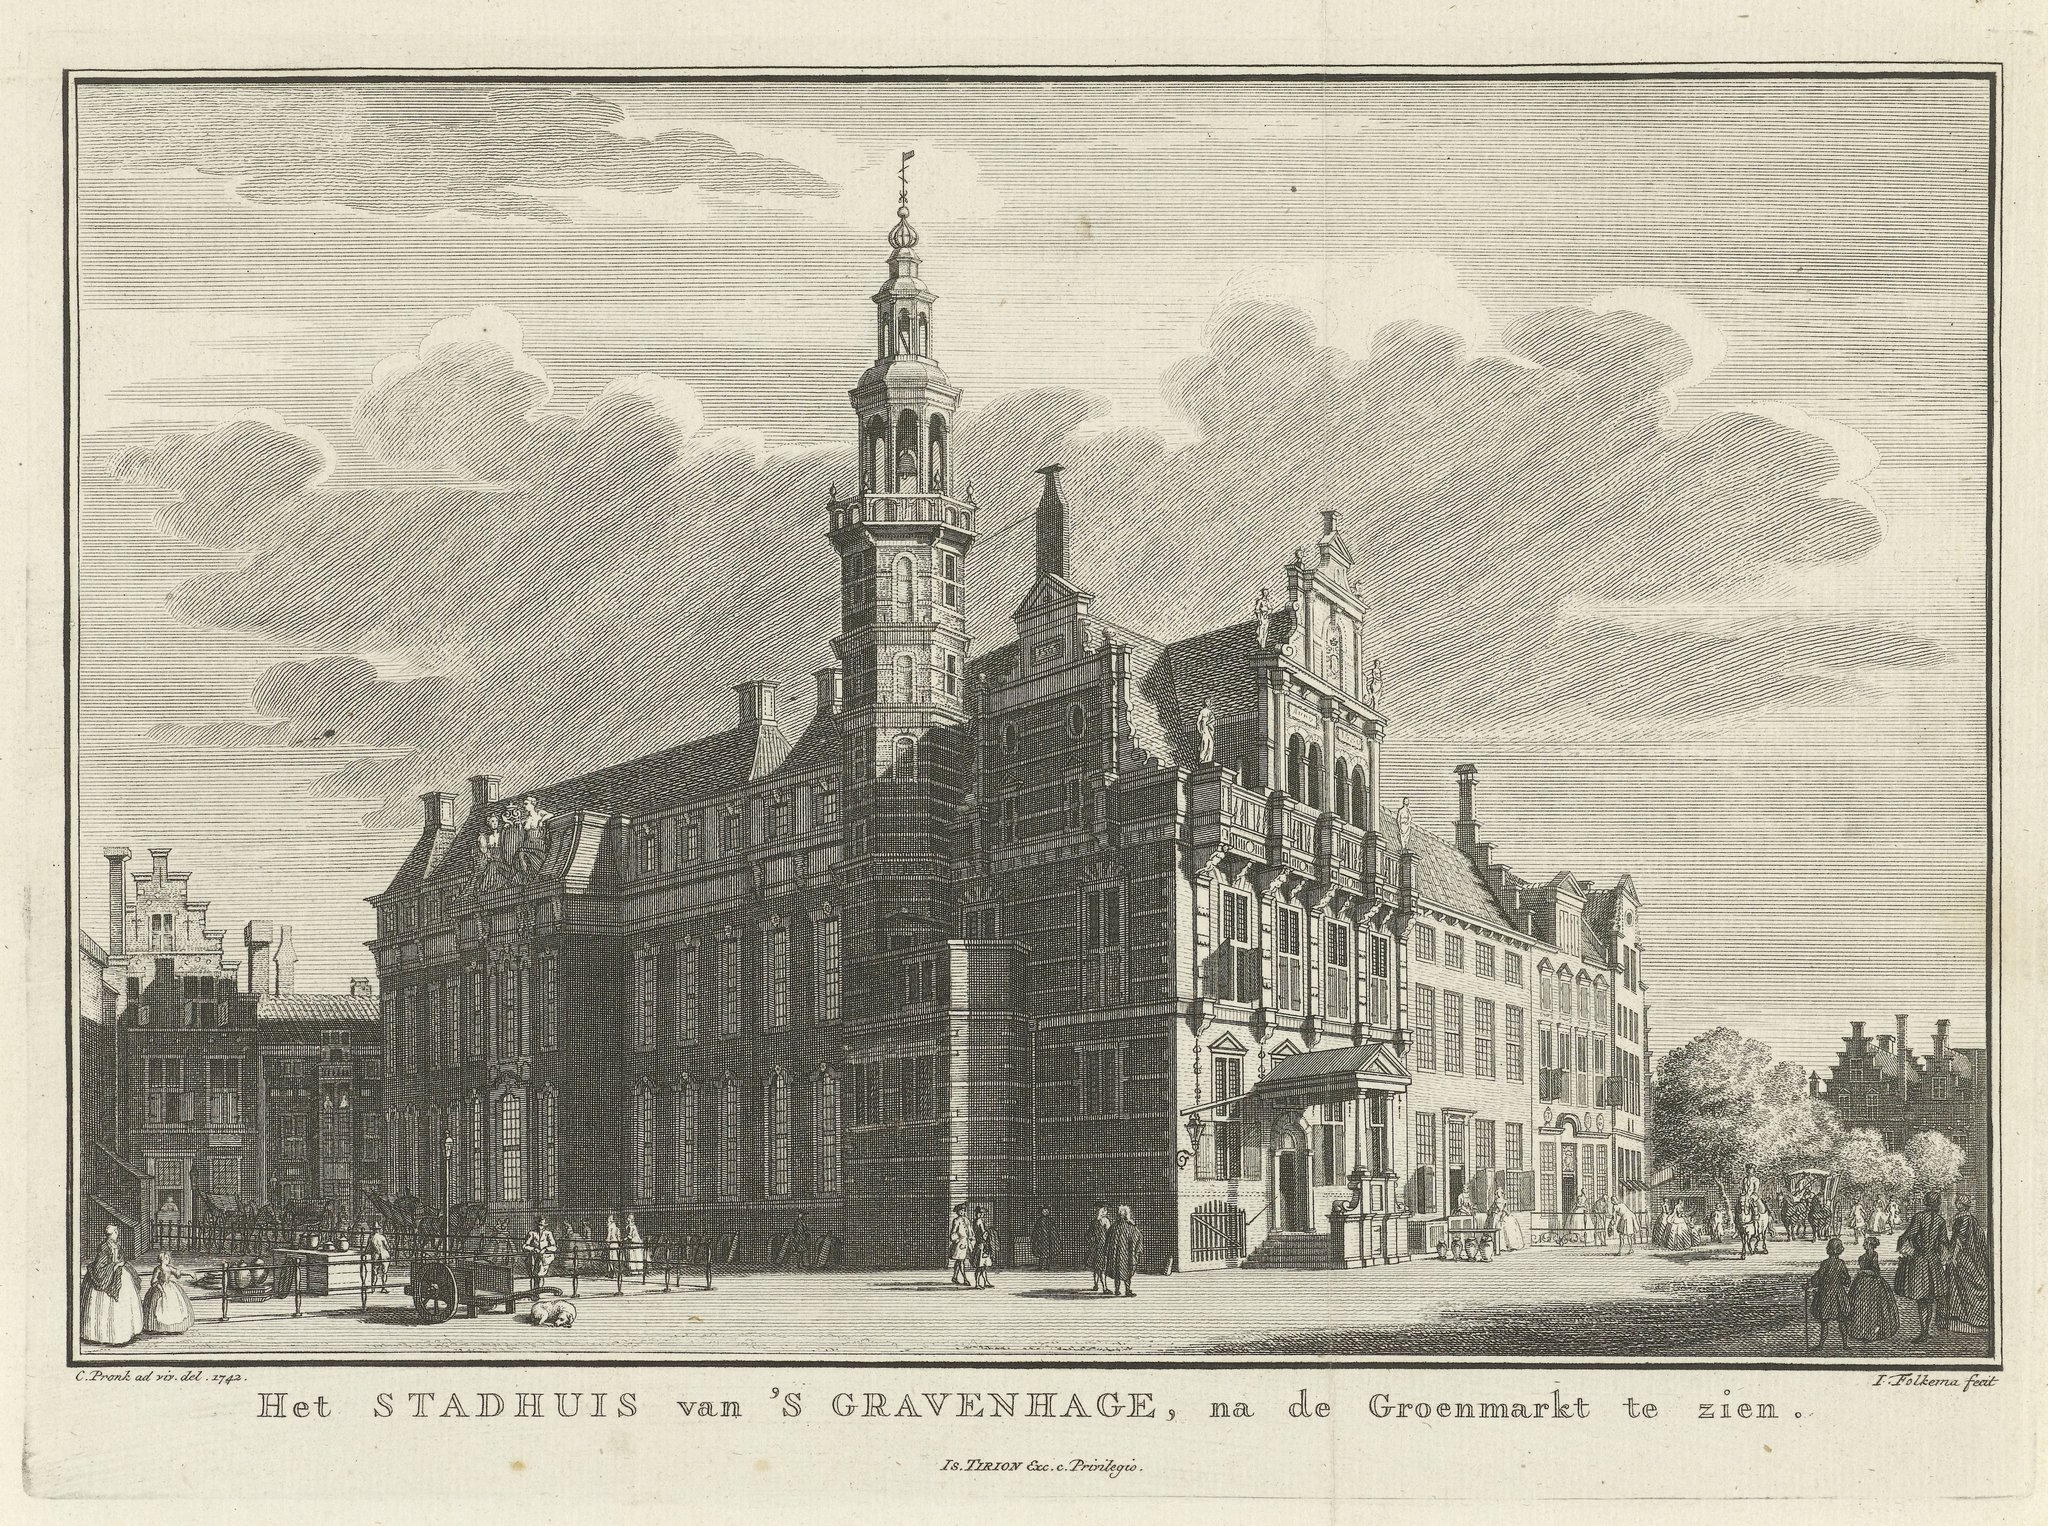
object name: print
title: Gezicht op het oude stadhuis te Den Haag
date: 1742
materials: paper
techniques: etching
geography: amsterdam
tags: townhall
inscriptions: collector's mark: Lugt 2228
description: Het stadhuis van Den Haag, gezien vanaf de Groenmarkt.